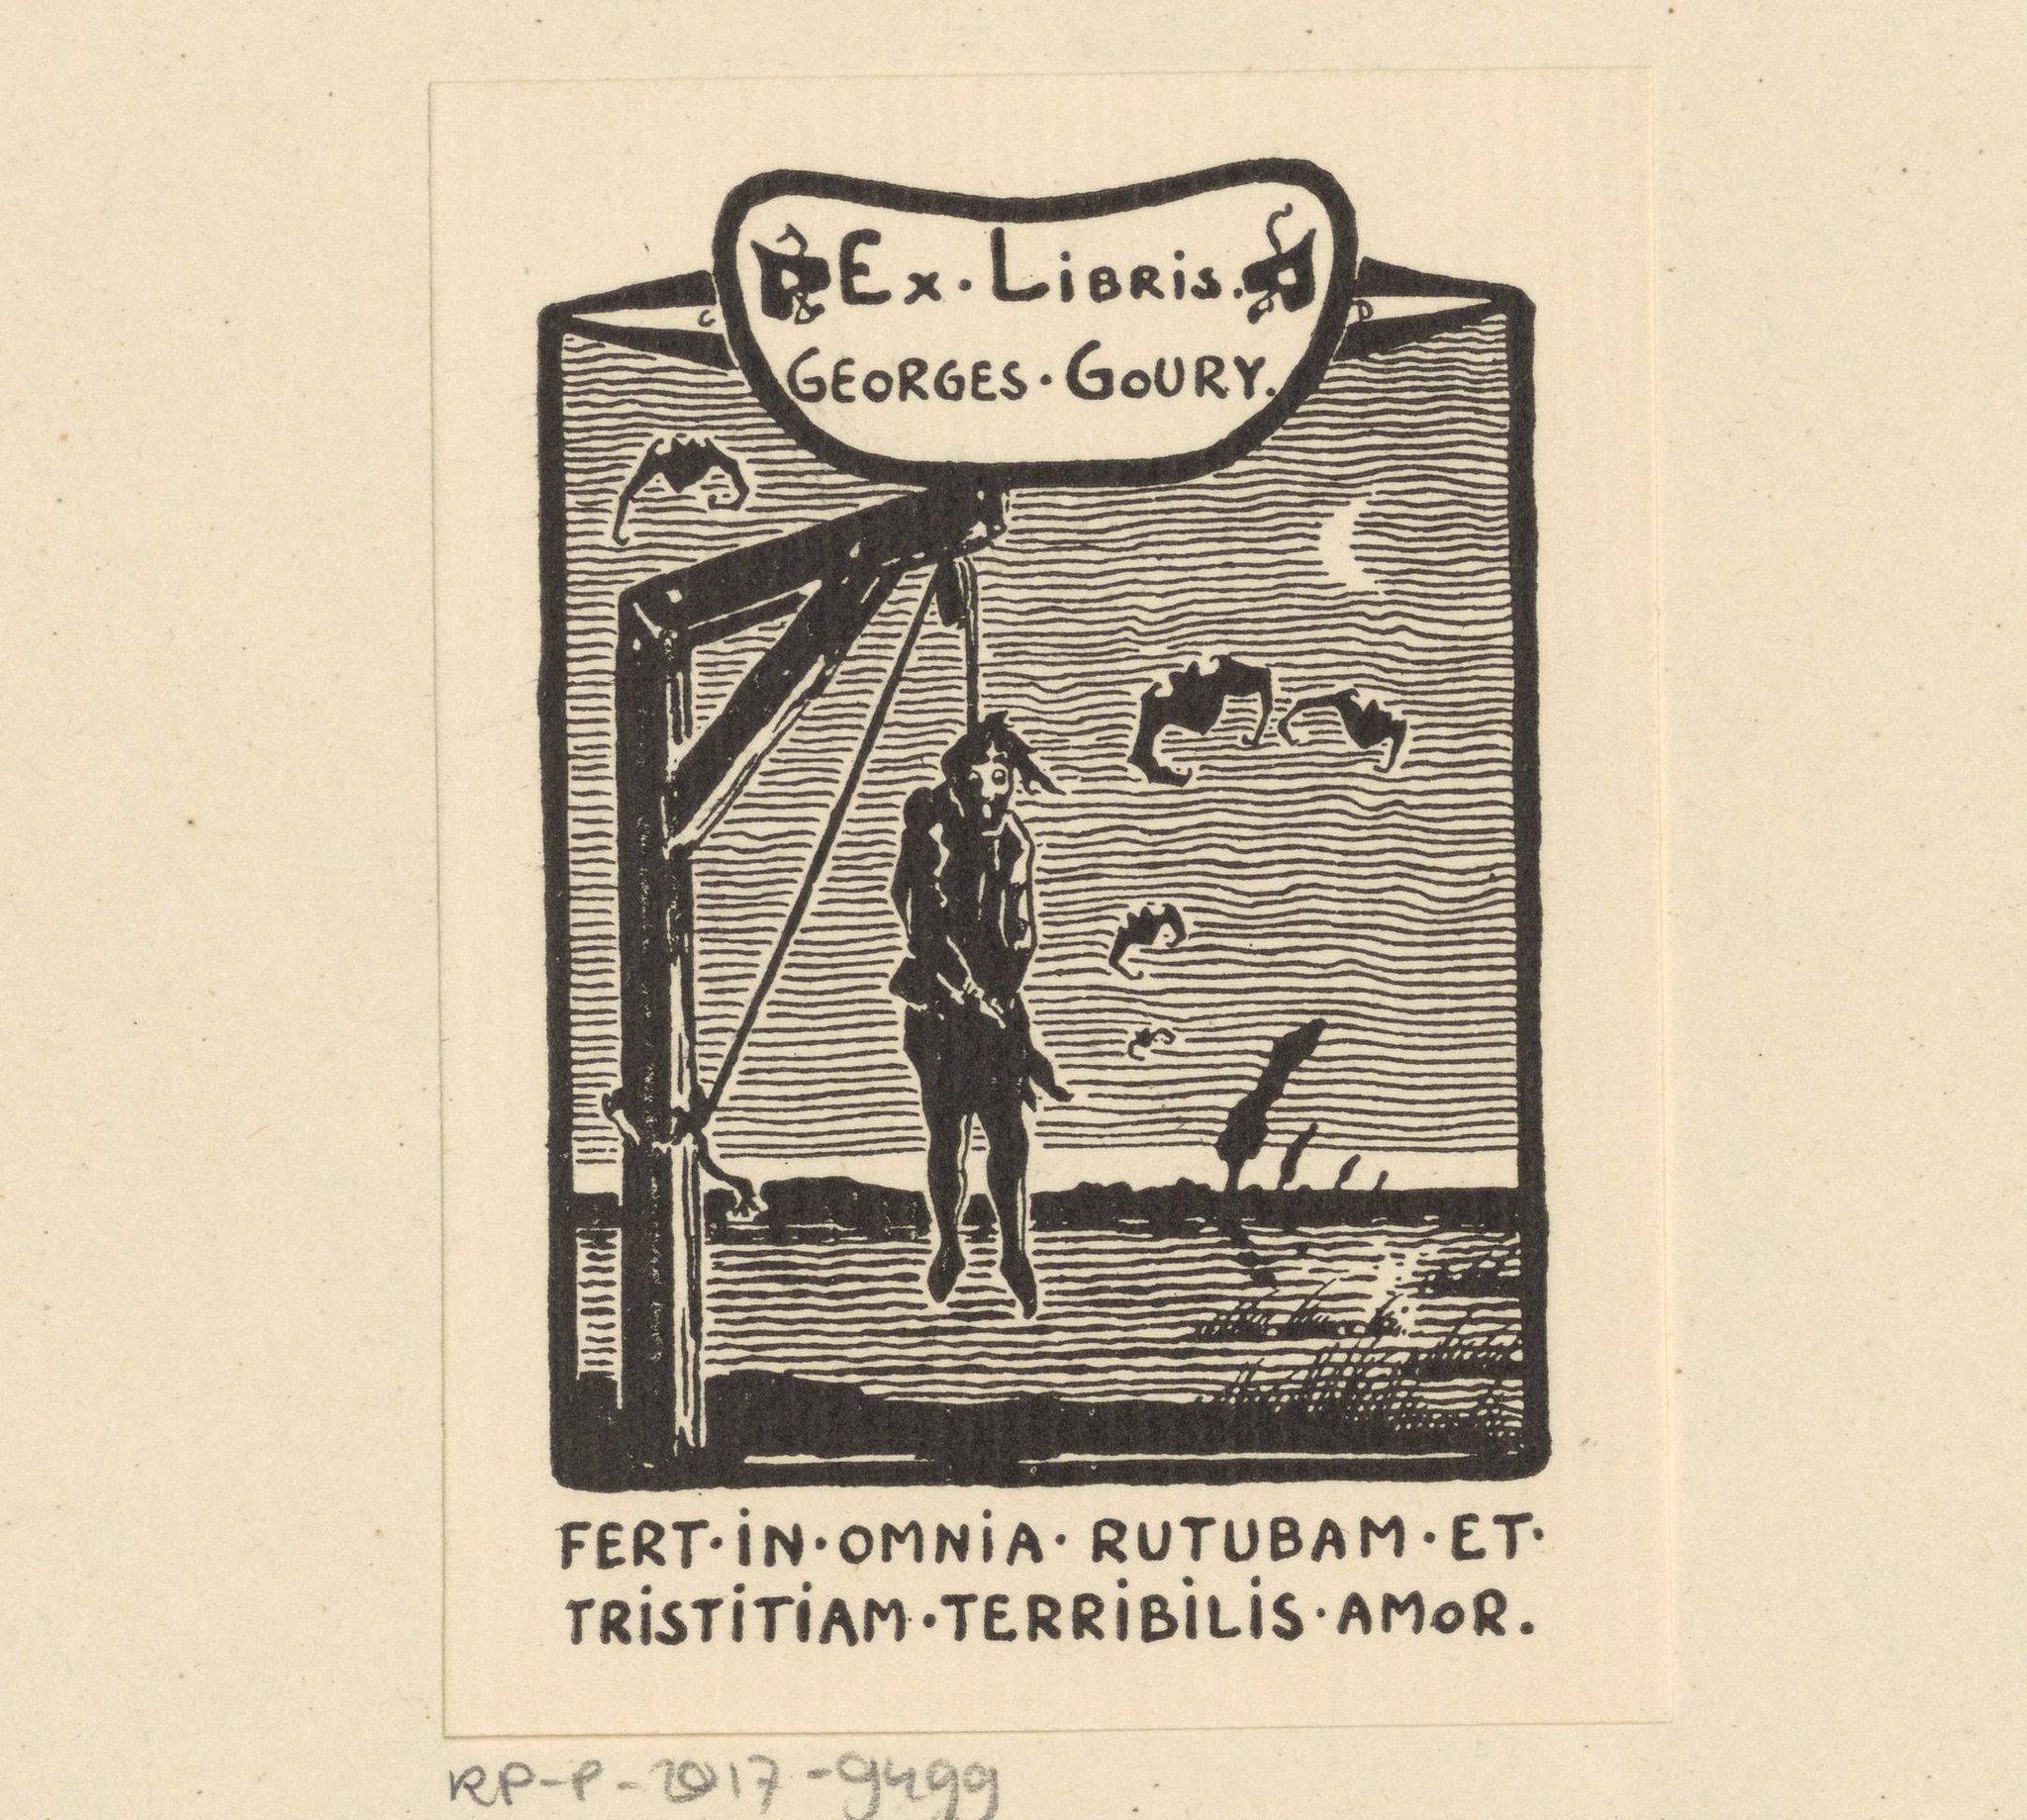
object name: bookplate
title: Ex libris van Georges Goury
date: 1887-1913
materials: paper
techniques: printing block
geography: france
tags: instruments of torture, execution or punishment: gallows